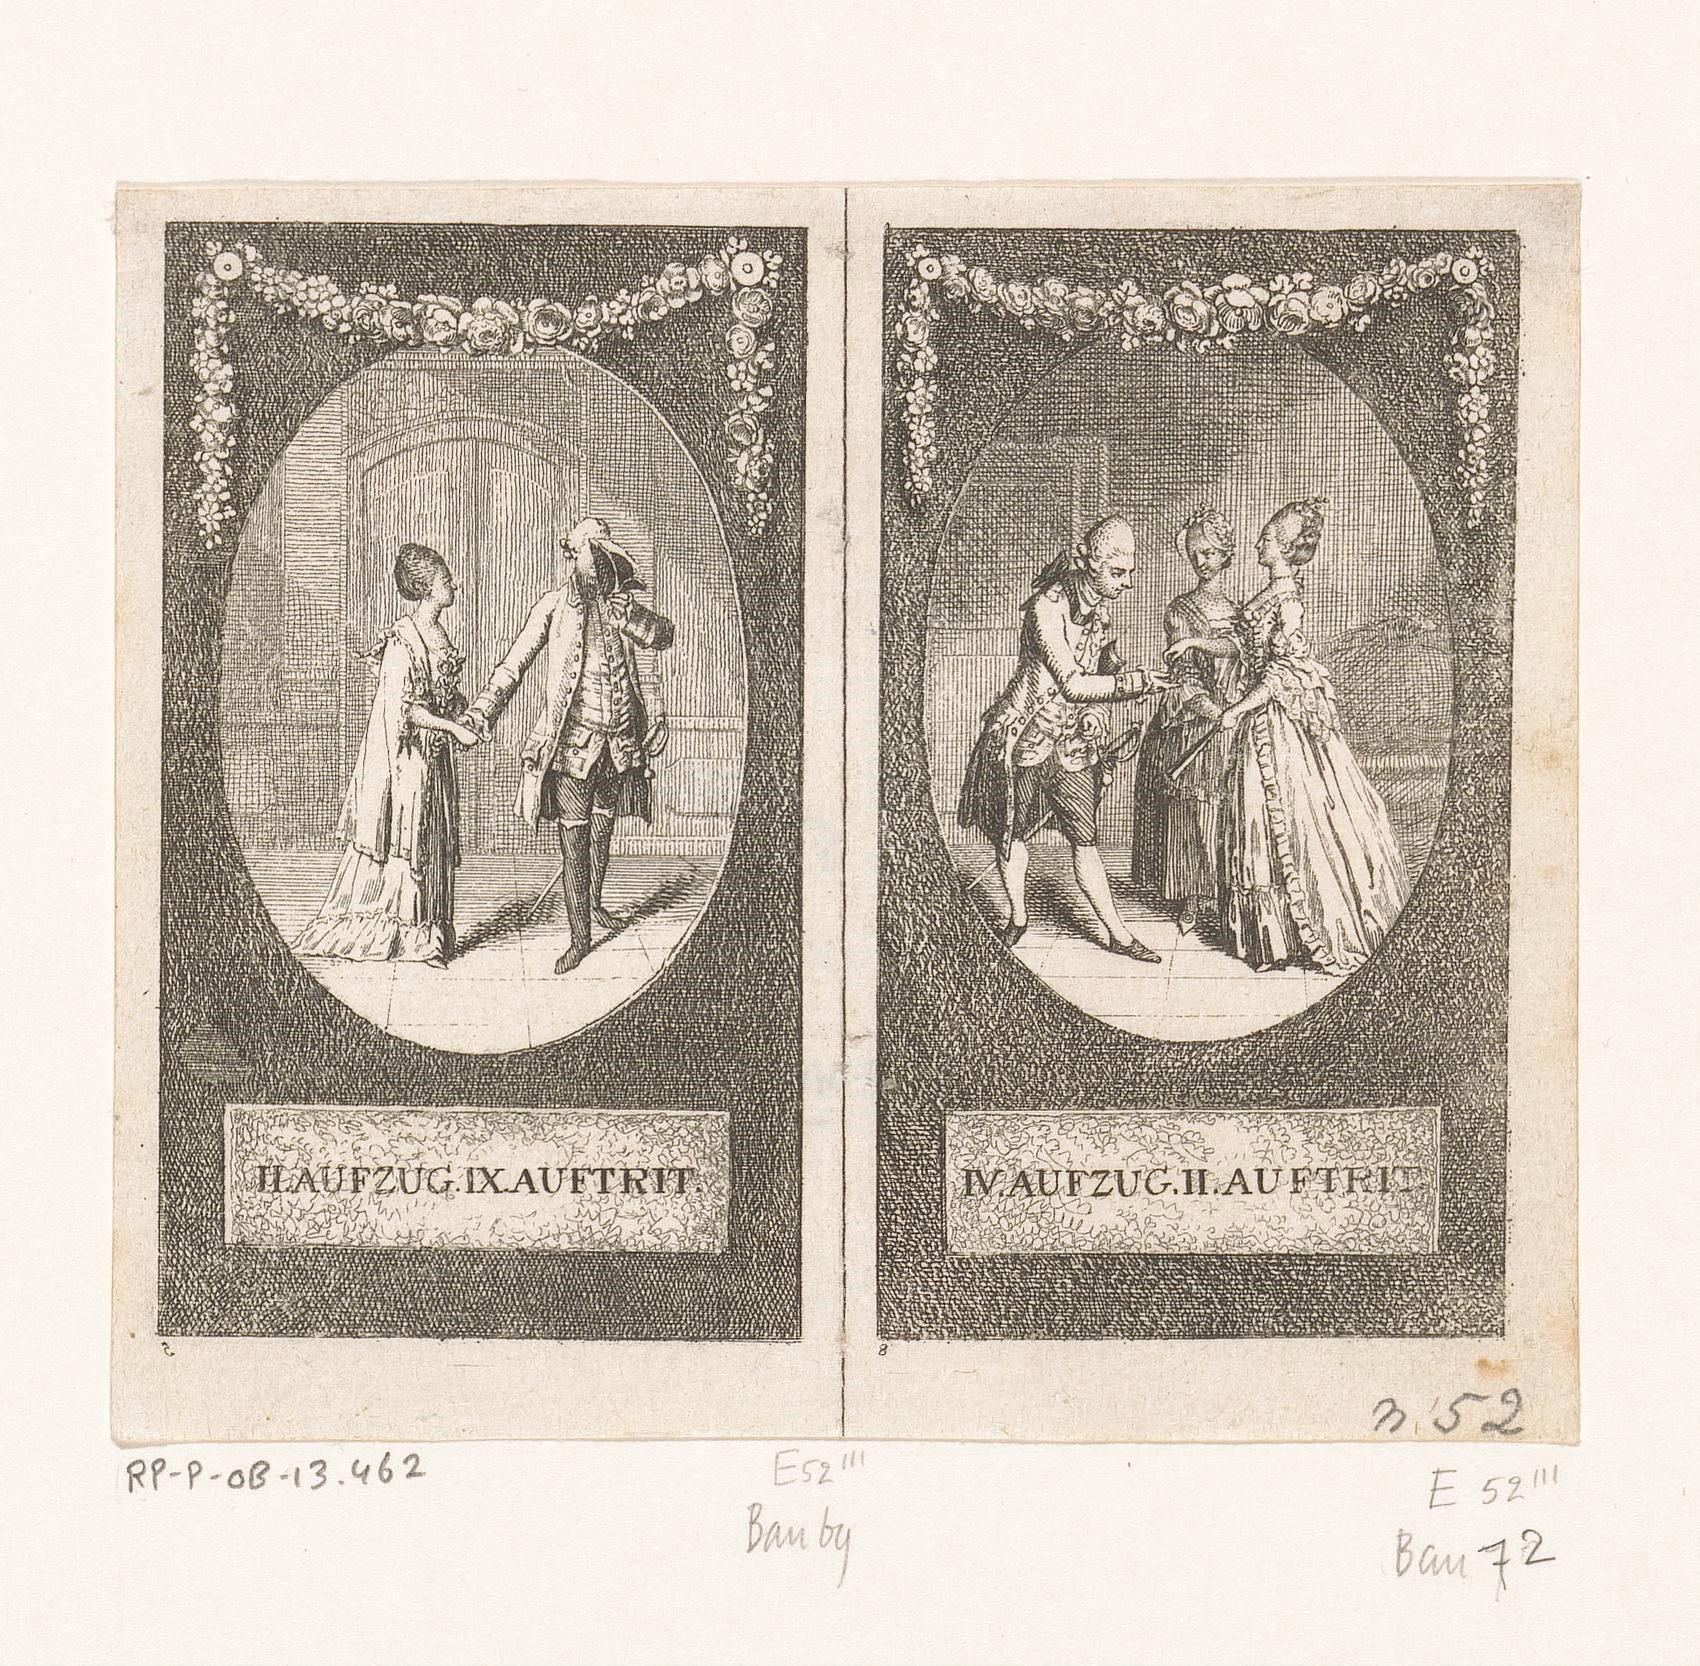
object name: print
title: Twee scènes uit Minna von Barnhelm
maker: daniel nikolaus chodowiecki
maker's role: draughtsman, print maker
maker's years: 1726-1801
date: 1769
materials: paper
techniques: etching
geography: berlin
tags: literary characters and objects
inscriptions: collector's mark: Lugt 2228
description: Deze prenten maken onderdeel uit van een serie van twaalf scènes die het toneelstuk 'Minna von Barnhelm' van Gotthold Ephraim Lessing illustreren (eerste uitvoering 1767). Chodowiecki bracht het toneelstuk twee keer in prent, een met onderschriften in het Frans en een met onderschriften in het Duits. Bij beide series werden de scènes op een plaat geëtst. Deze prenten horen bij de Duitse serie, gebruikt als boekillustratie in: 'Genealogischen Calender auf das Jahr 1770'.